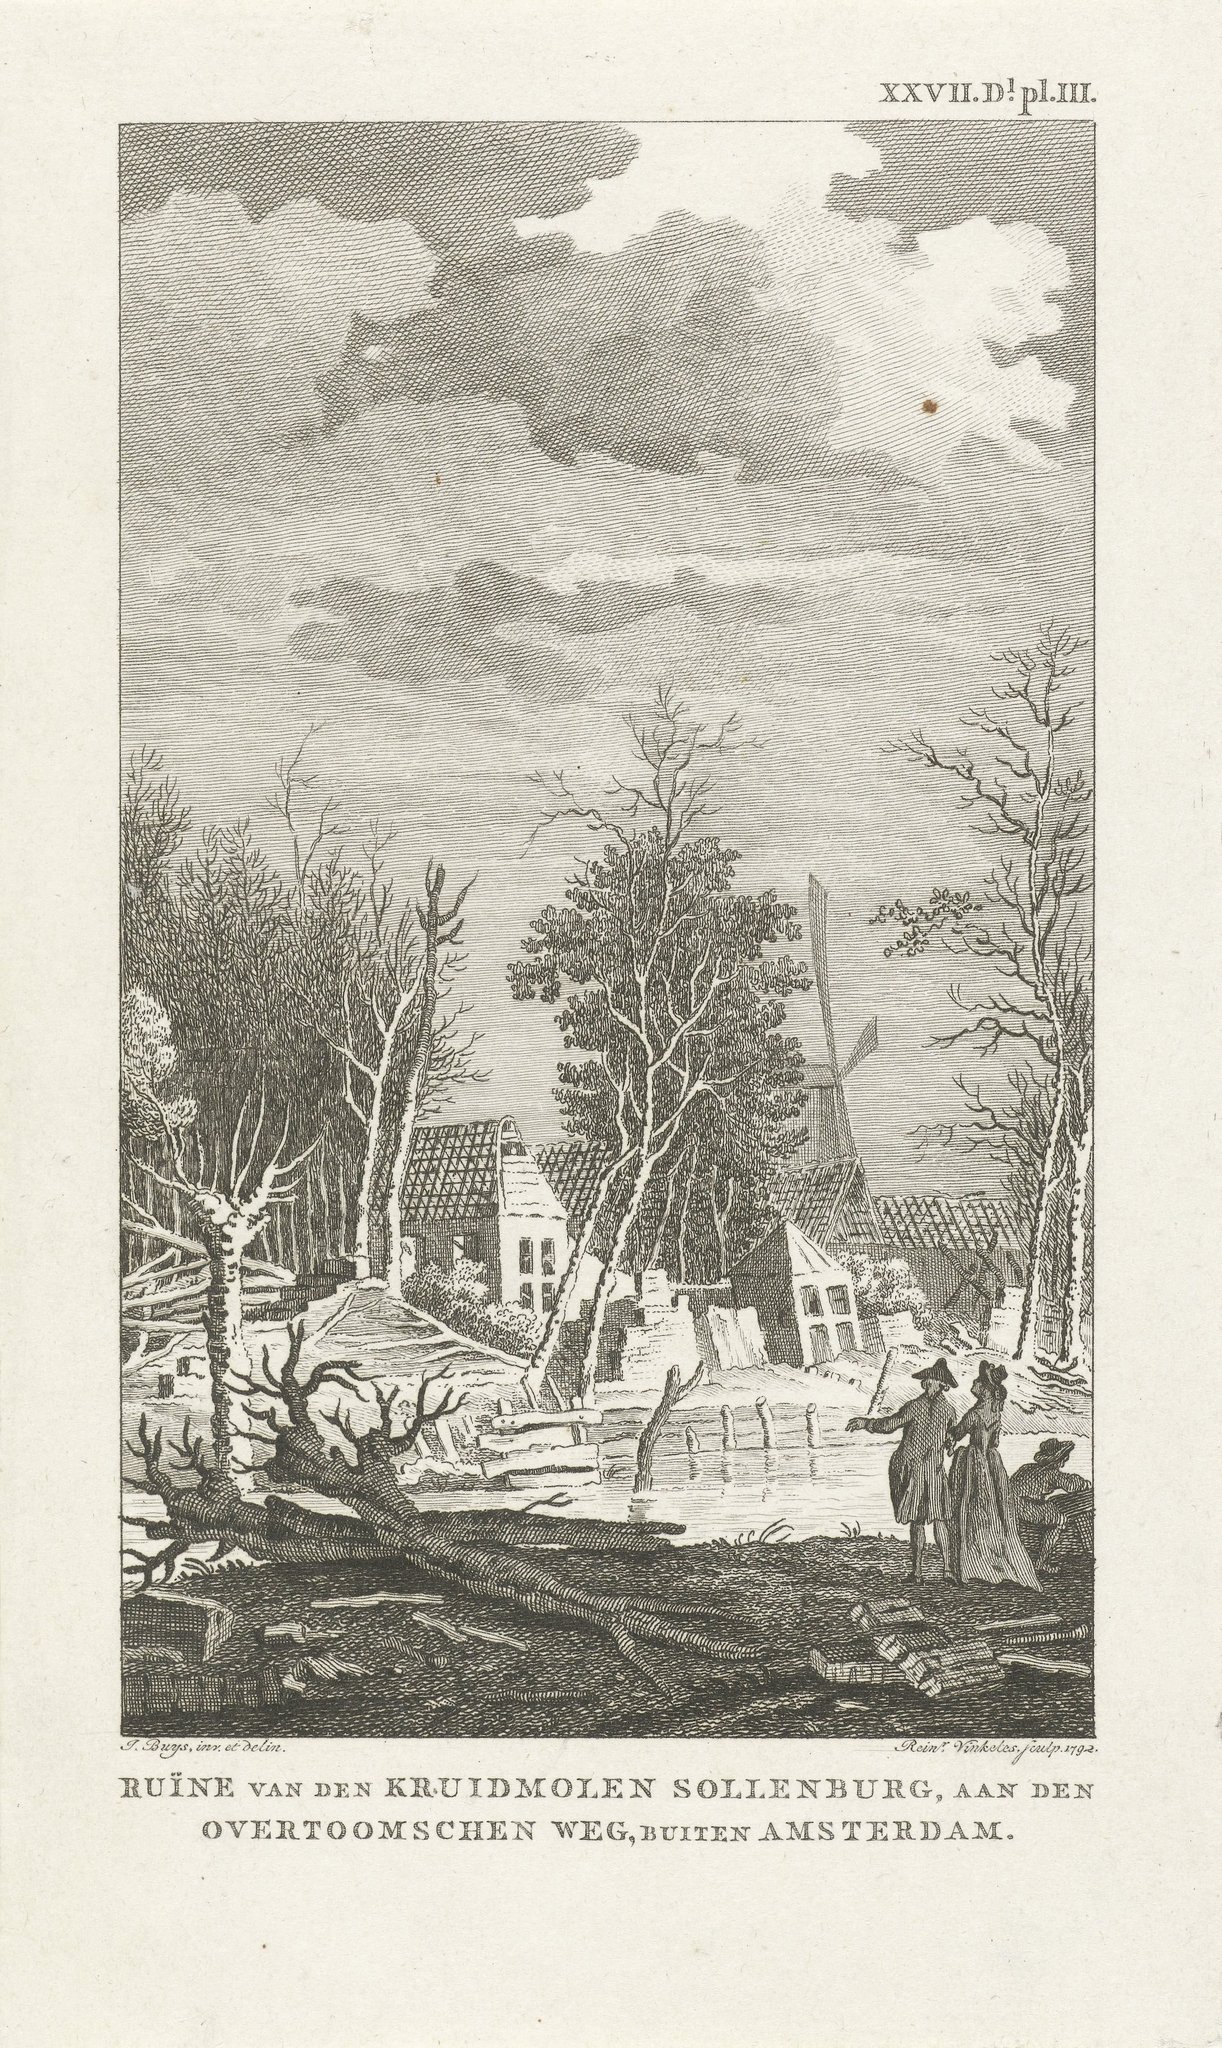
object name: print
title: Ruïne van den Kruidmolen Sollenburg, aan den Overtoomschen Weg, buiten Amsterdam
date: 1792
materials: paper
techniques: etching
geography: northern netherlands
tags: gunpowder disaster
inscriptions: collector's mark: Lugt 2228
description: Gezicht op de ruïne van de kruitfabriek in de kruitmolen Sollenburg aan de Overtoom te Amsterdam na de ontploffing op 14 augustus 1758. Gemerkt rechtsboven: XXVII. Dl. pl. III.